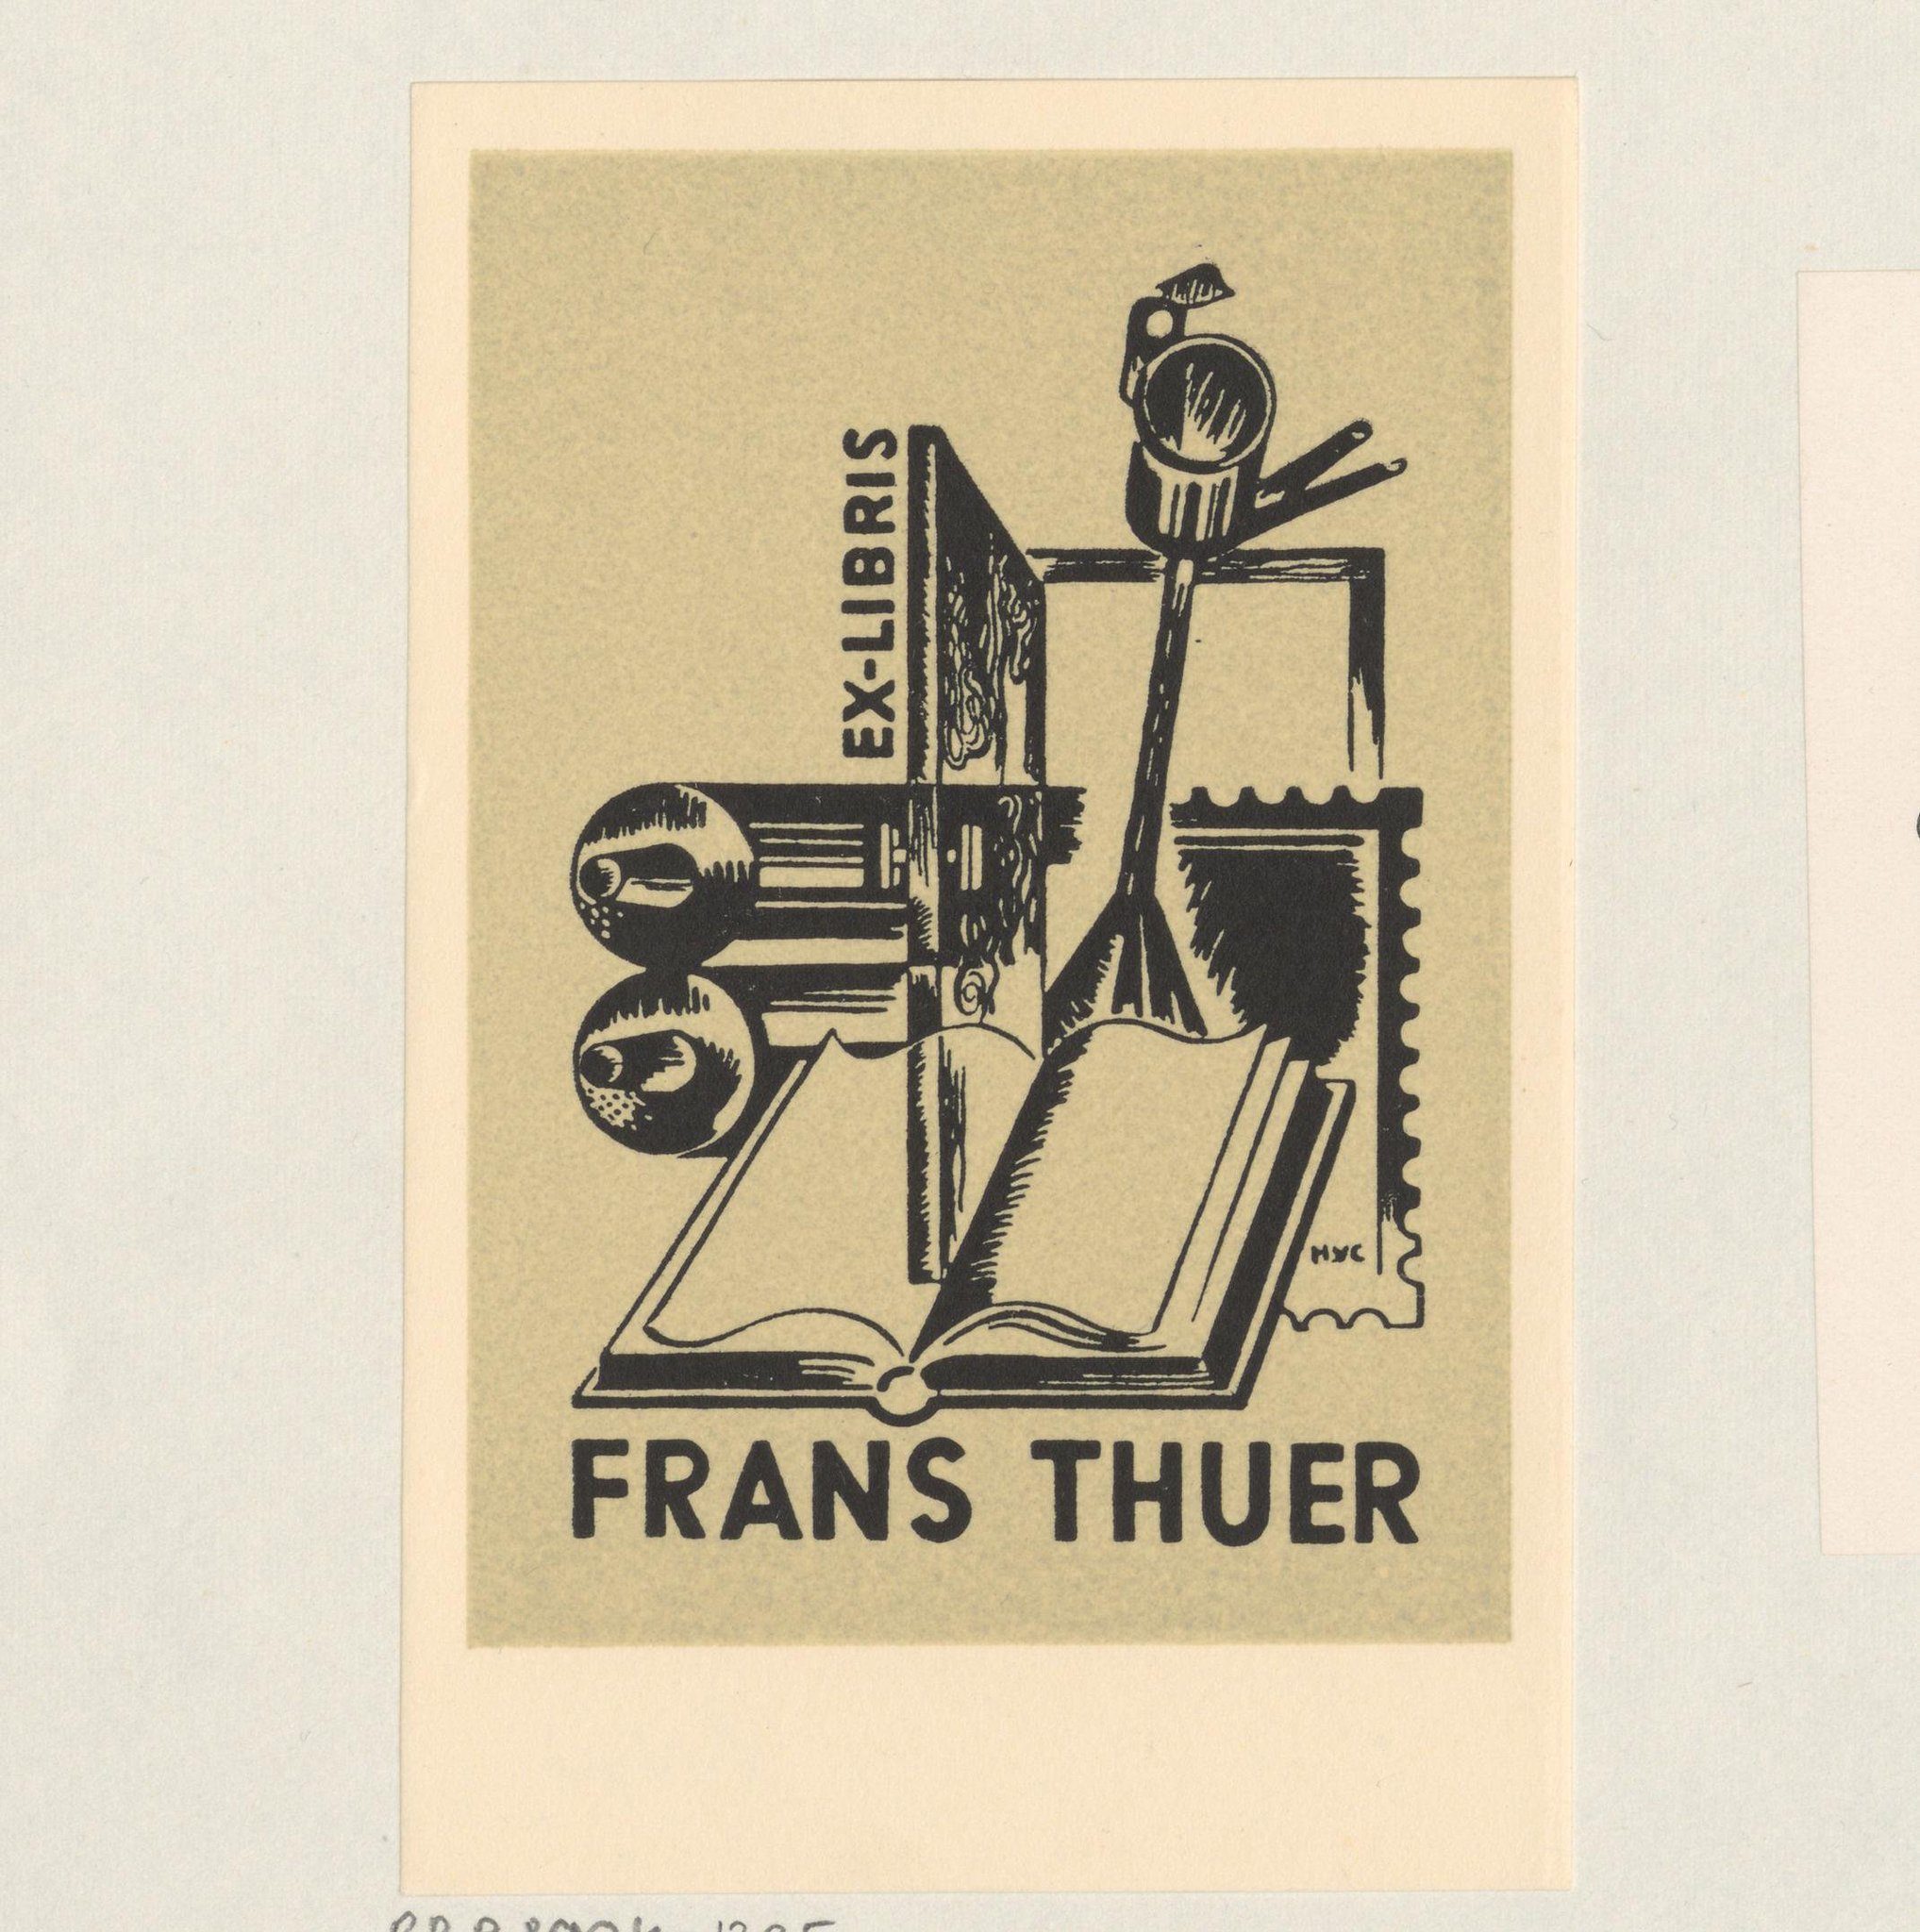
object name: bookplate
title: Ex libris van Frans Thuer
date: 1900-1904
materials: paper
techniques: planographic printing, printing block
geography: belgium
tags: stamp (~ postal matter), open door, book